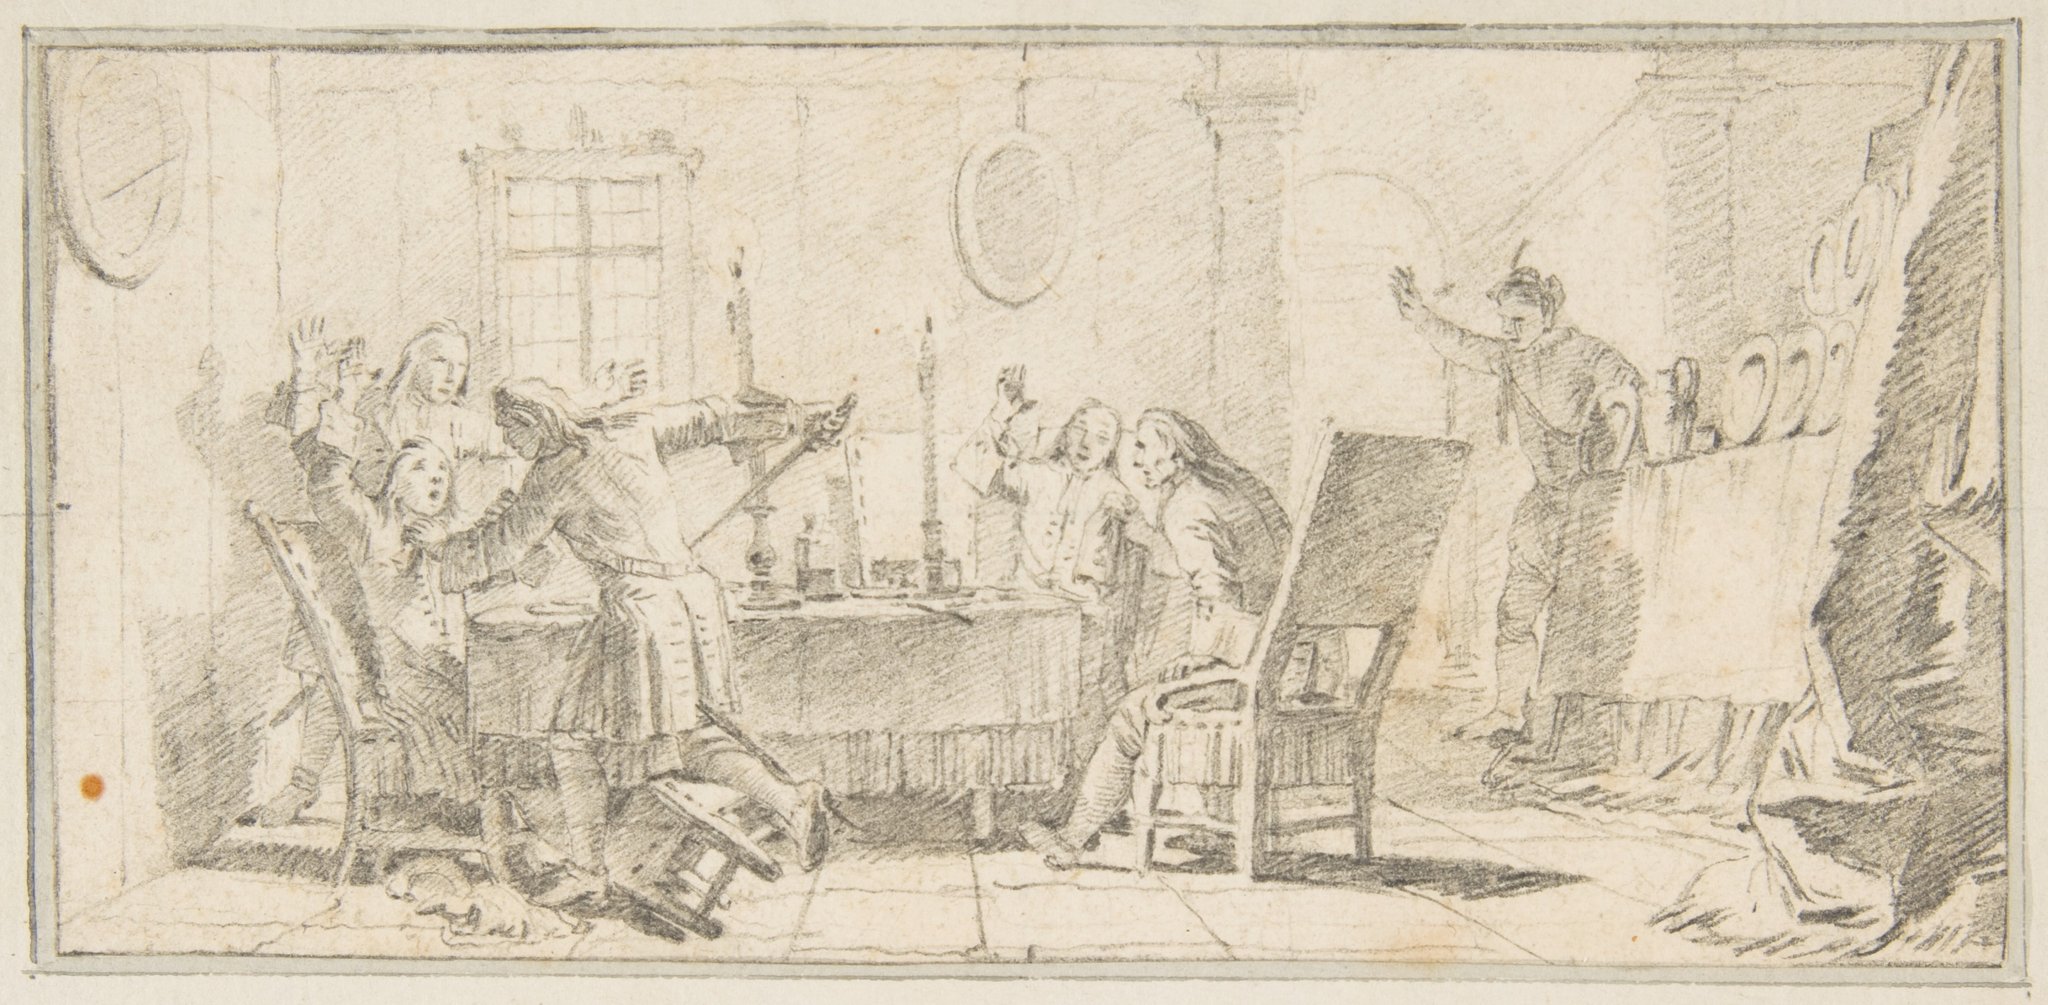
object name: drawing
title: Illustration for a Book: Scene of a Murder in an Interior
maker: giovanni battista tiepolo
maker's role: artist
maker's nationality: italian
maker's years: 1696-1770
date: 1696-1770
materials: chalk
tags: interiors,men